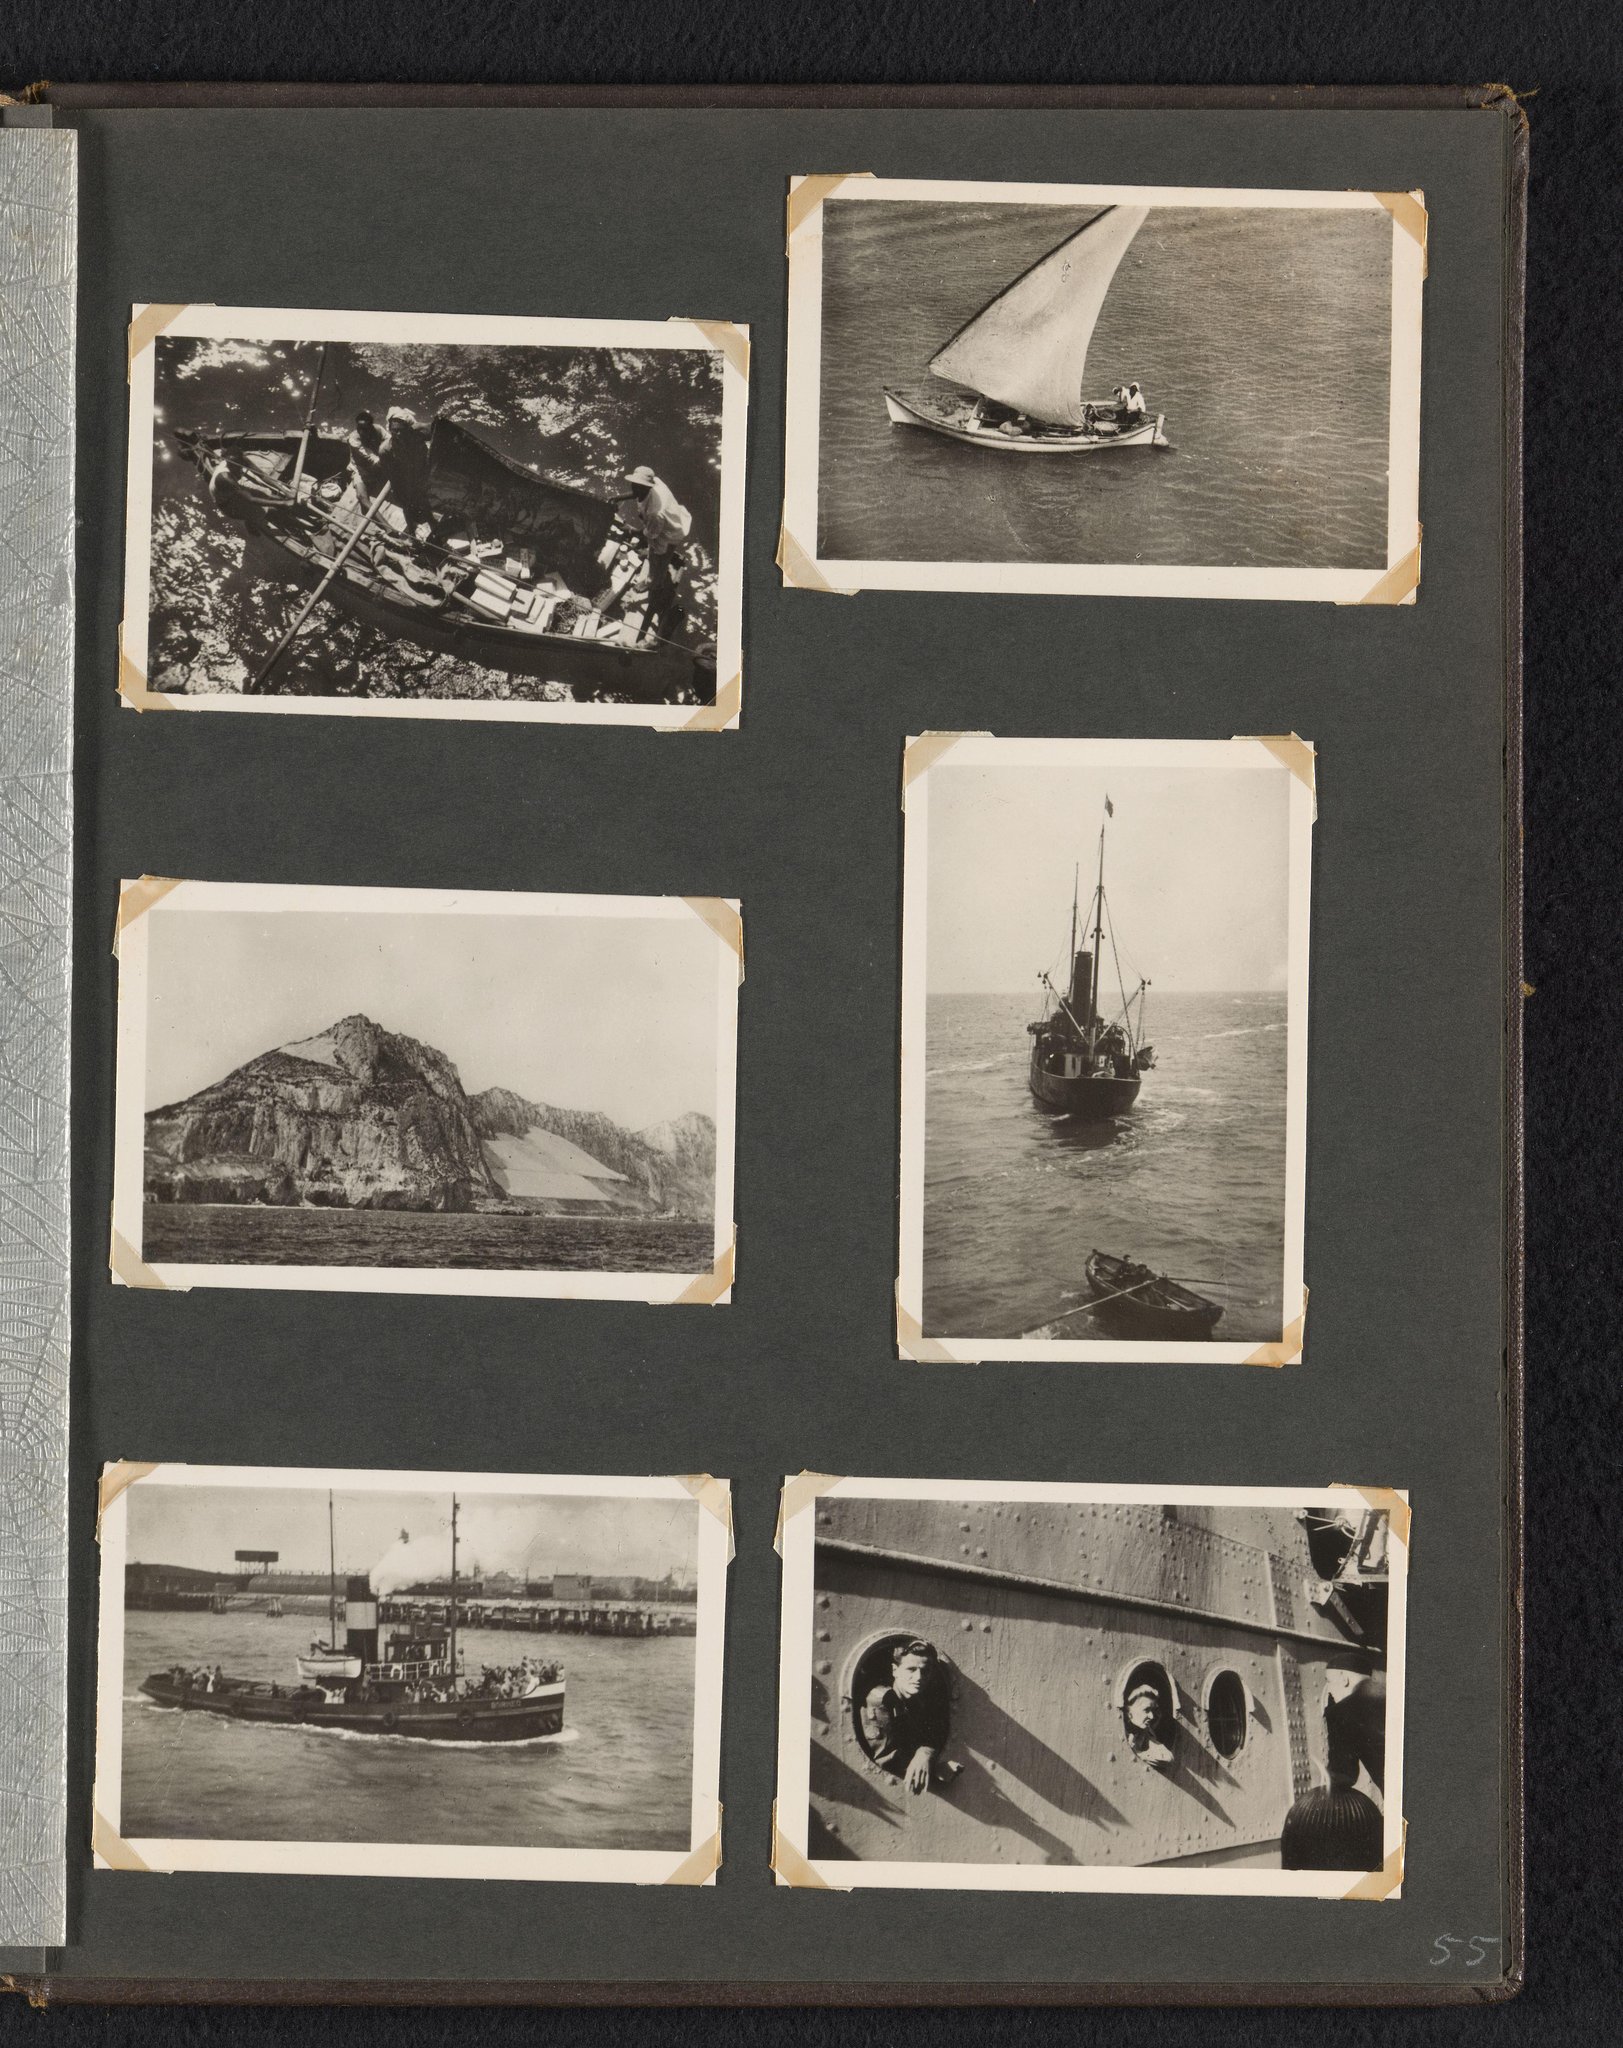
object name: photograph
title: Terugreis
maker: Anonymous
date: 1950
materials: cardboard, photographic support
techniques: gelatin silver print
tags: france, engineer, sailing-ship, sailing-boat, coast, steamship, motorship, dutch east indies, the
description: Albumblad met zes foto's van andere vaartuigen en de rots van Gibraltar, genomen vanaf een schip tijdens de terugreis naar Nederland. Onderdeel van het fotoalbum 'Mijn jaren in Indië' met foto's over de militaire acties in Nederlands-Indië.